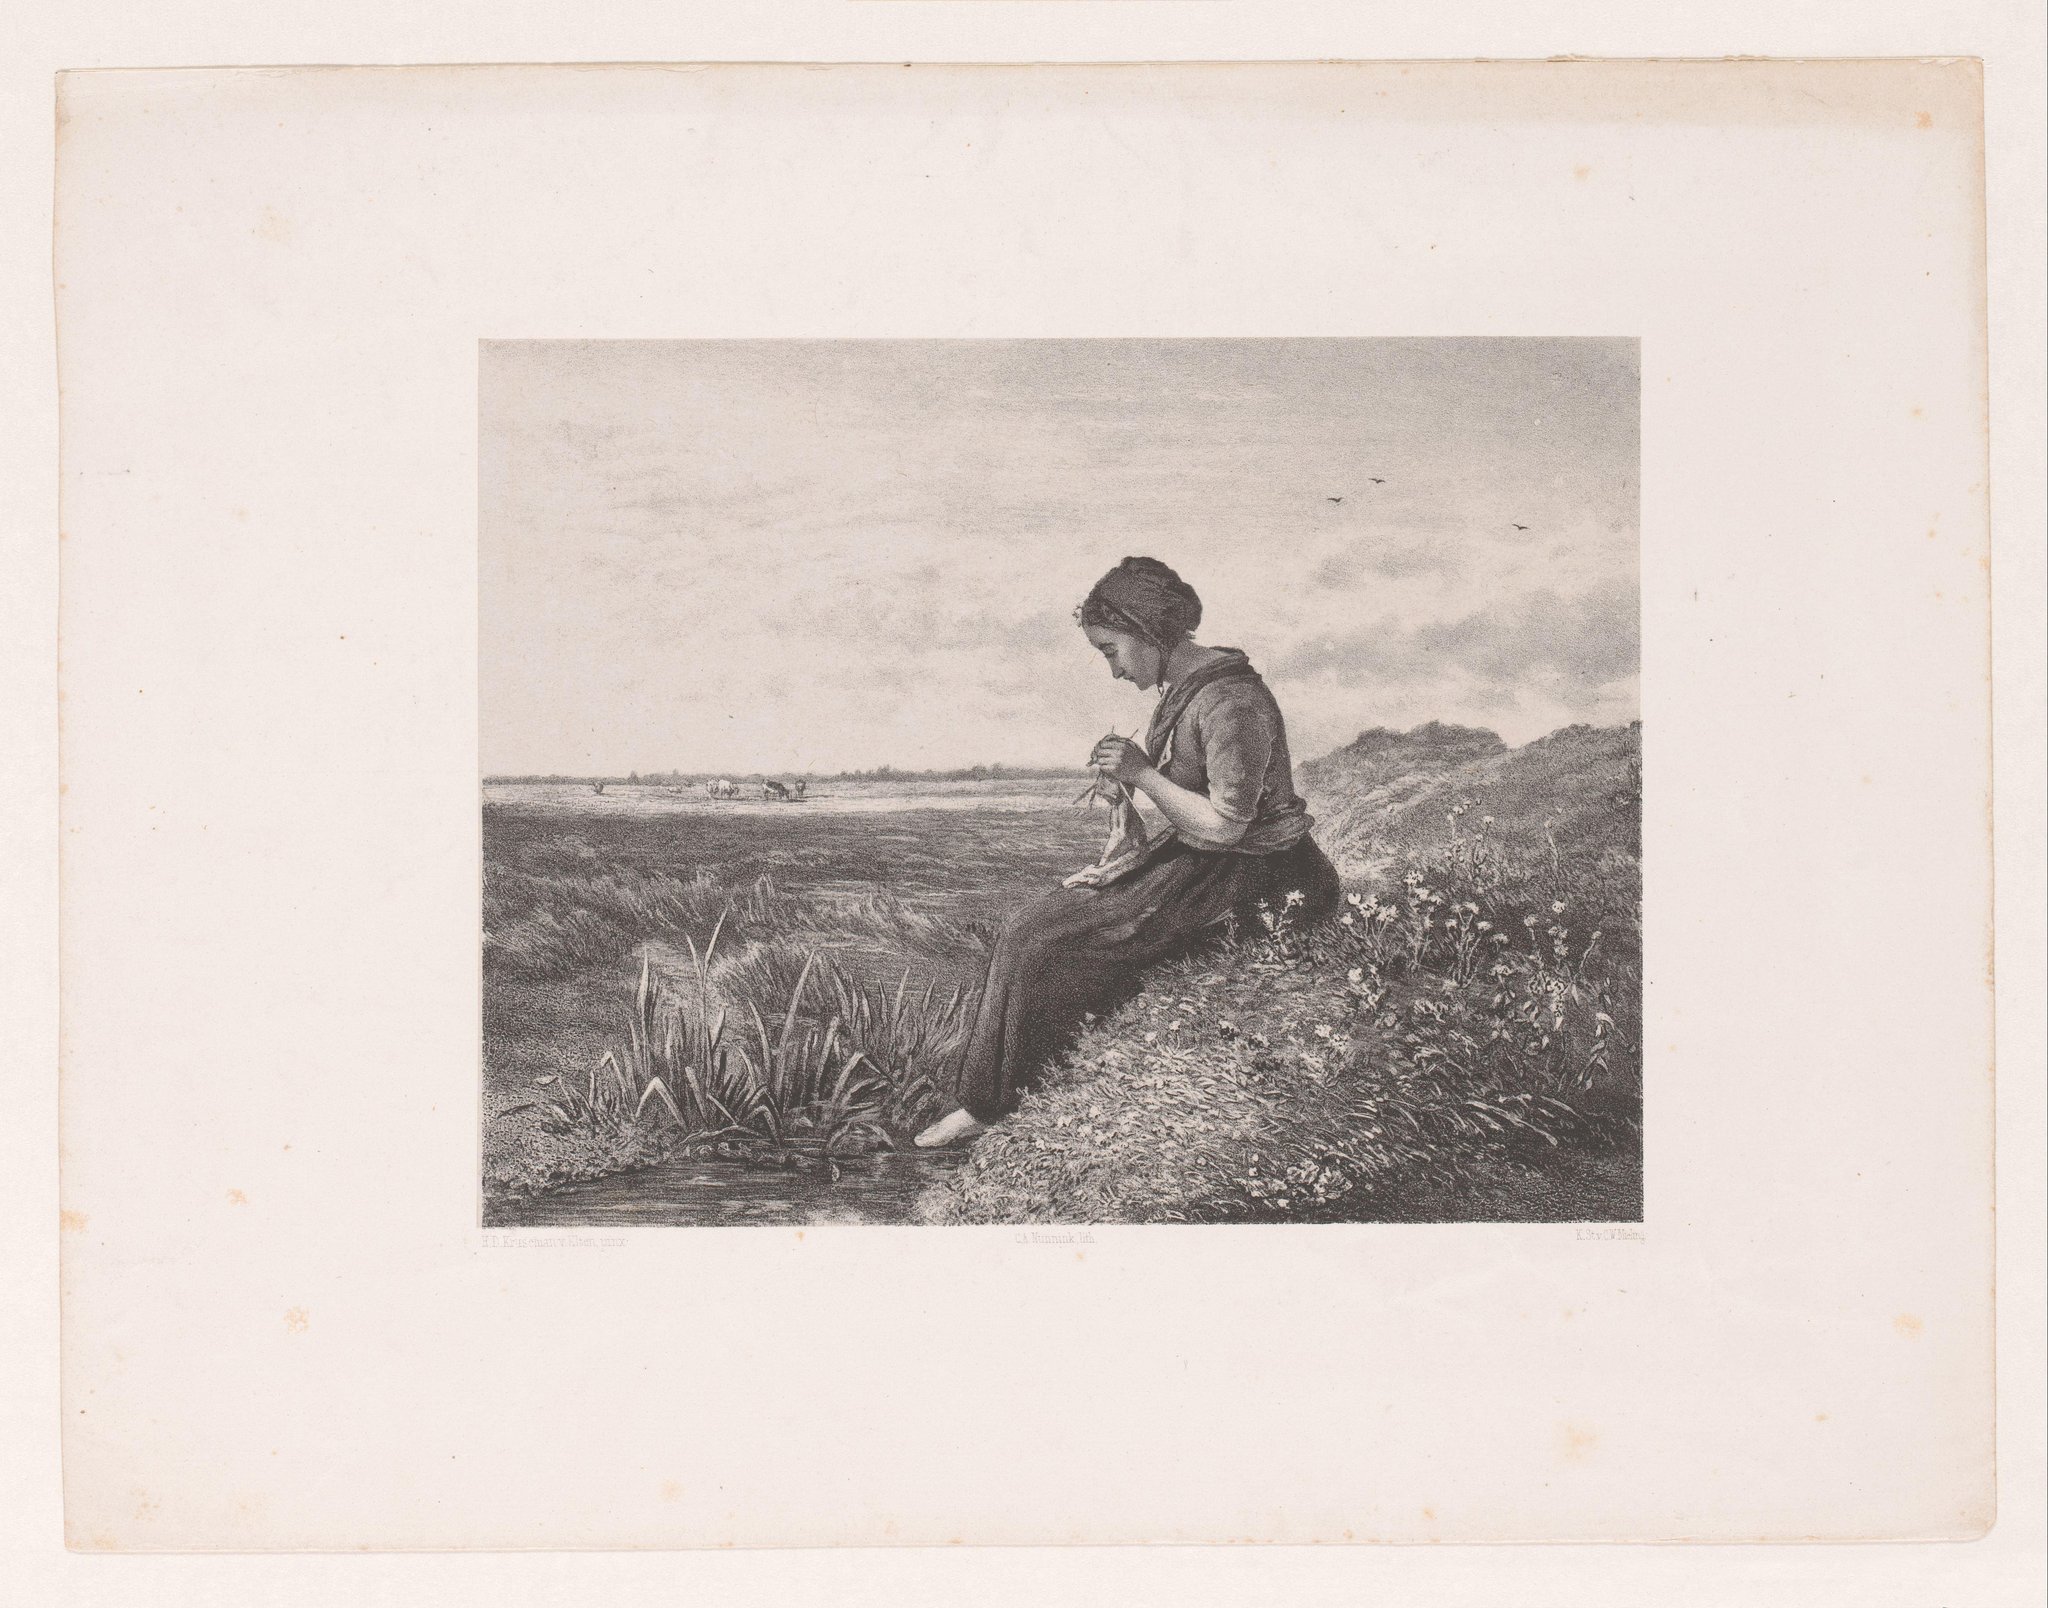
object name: print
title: Breiende jonge vrouw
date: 1847-1865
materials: paper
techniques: lithograph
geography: the hague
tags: knitting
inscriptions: collector's mark: Lugt 2228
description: Gezeten op een heuvel zit een breiende jonge vrouw. In de achtergrond grazen koeien op de wei.